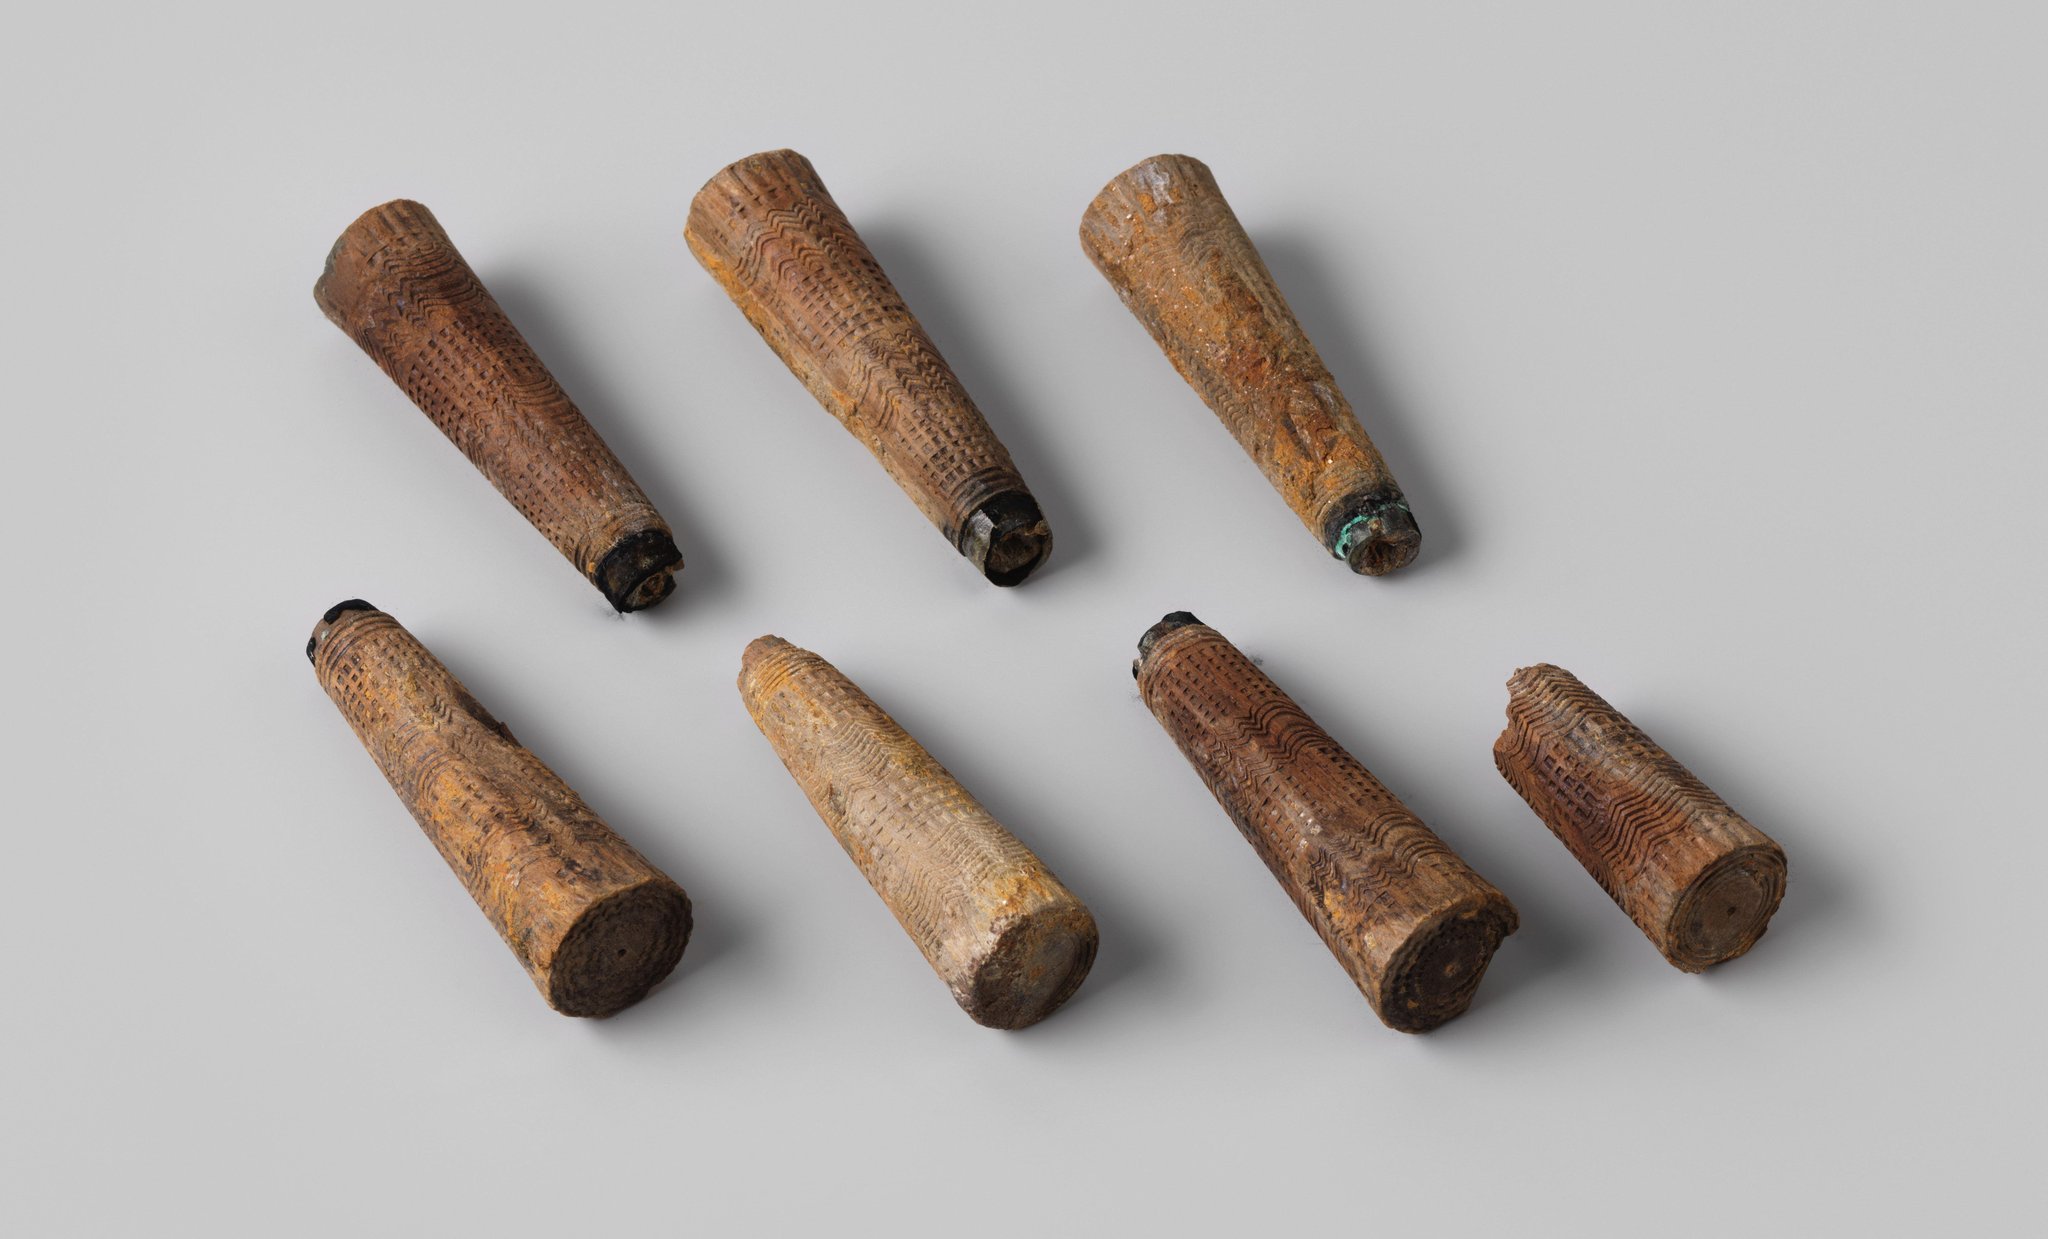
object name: knife handle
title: Messenheften en losse koperring uit het wrak van de Oost-Indiëvaarder Hollandia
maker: Anonymous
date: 1700-1743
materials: copper, wood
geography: netherlands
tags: verenigde oostindische compagnie, hollandia (schip), annet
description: Knife, handle, cylindrical: tapering; id. NG 1979-403H, ferrules, id. NG 1980-27H426.